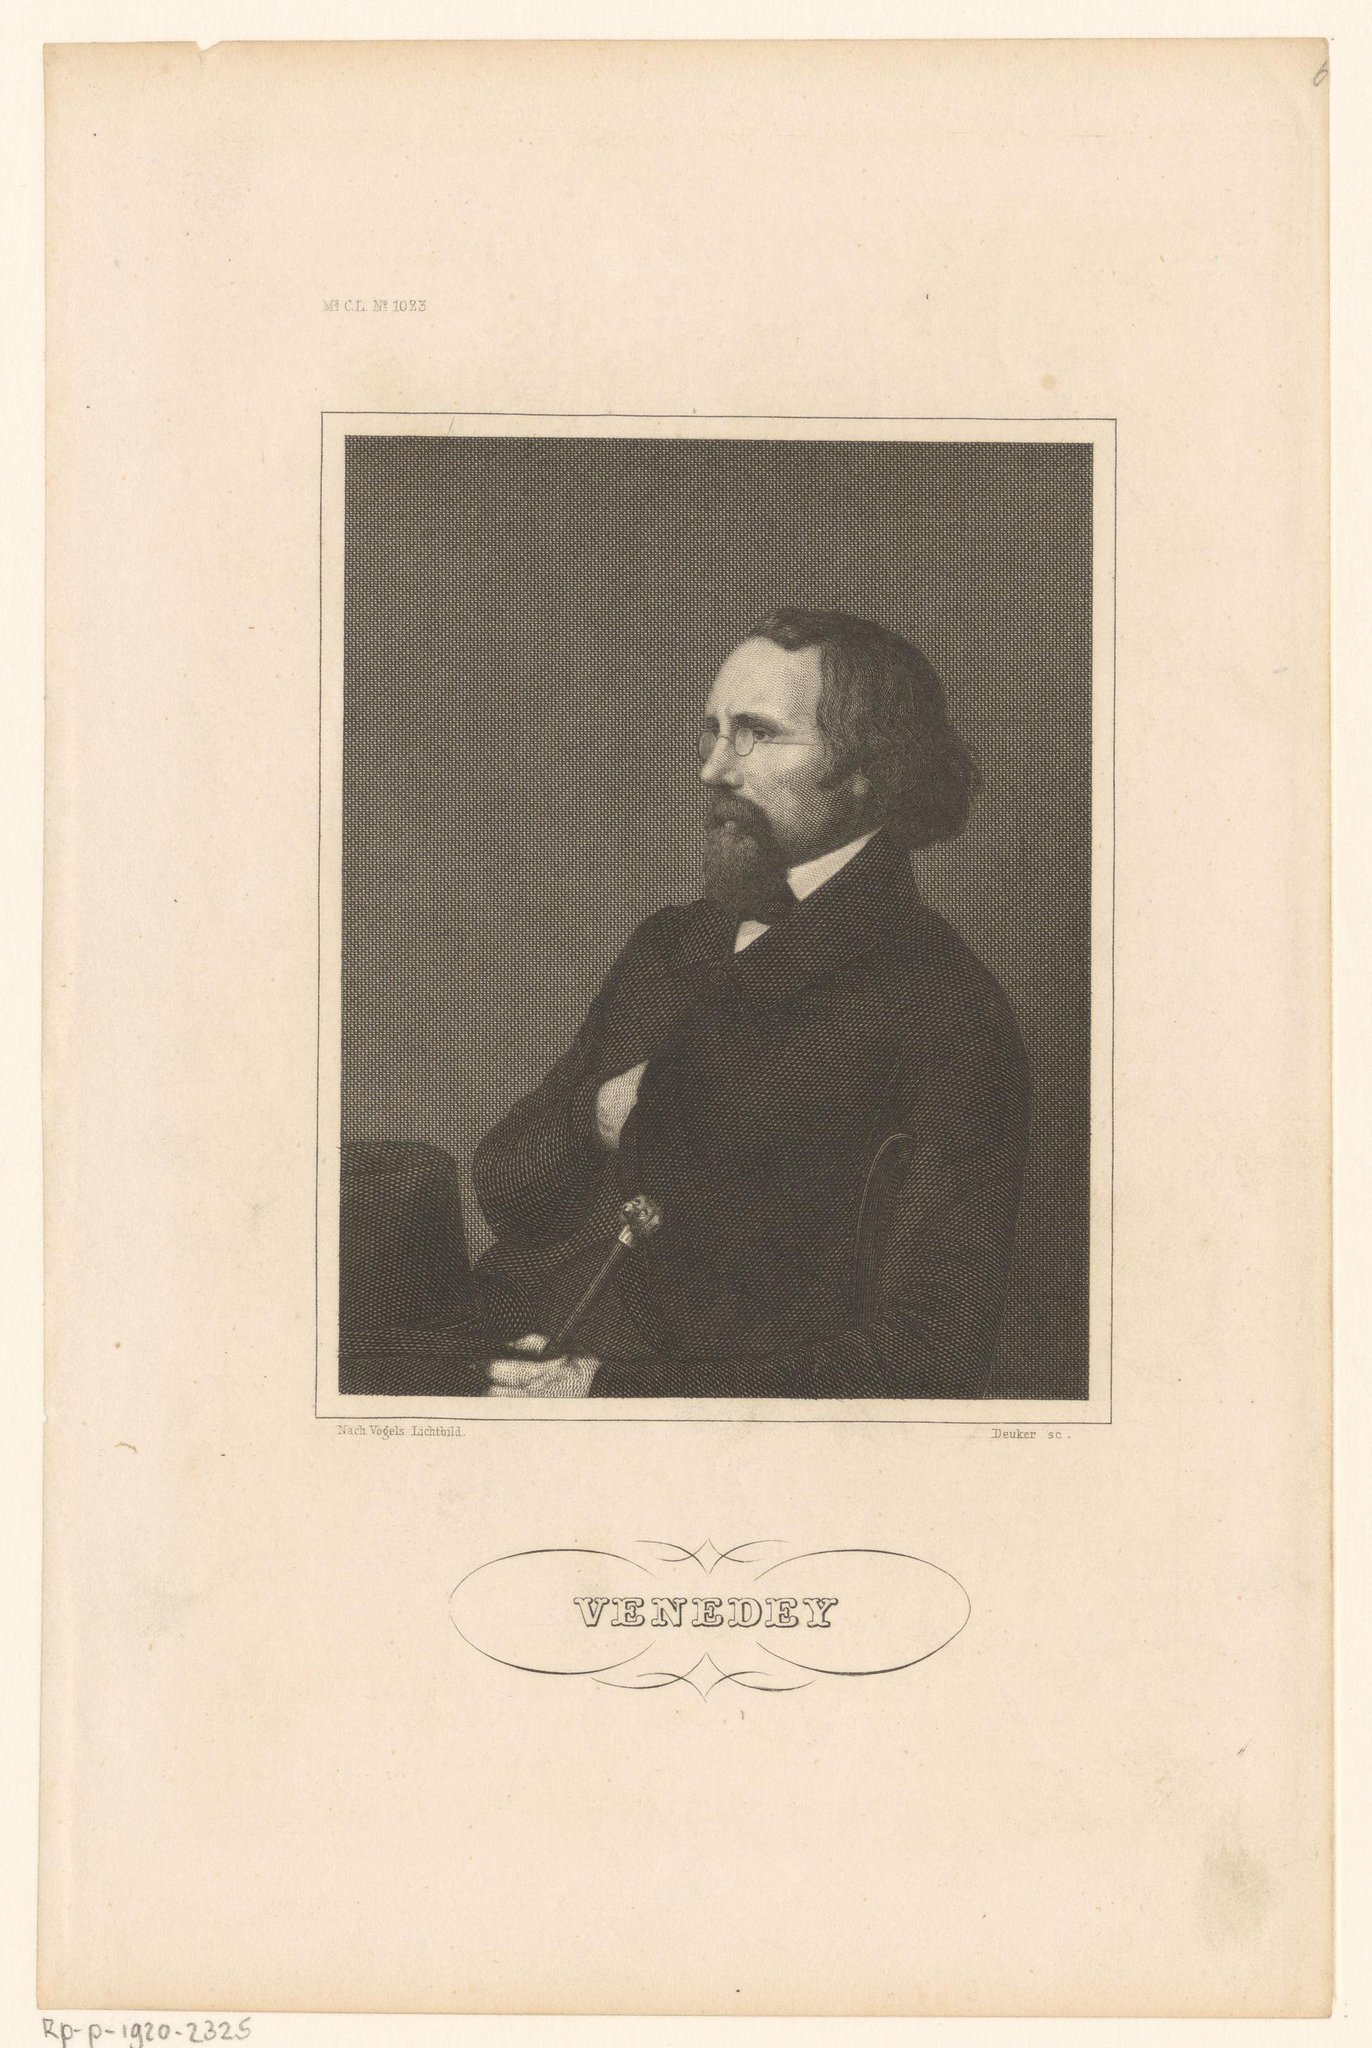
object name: book illustration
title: Portret van Jakob Venedey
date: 1840-1855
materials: paper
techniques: engraving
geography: germany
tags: politician, walking-stick, staff, portrait of a writer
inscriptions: collector's mark: Lugt 2228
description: Prent afkomstig uit: Conversations-Lexikon für die gebildeten Stände, voor het eerst uitgegeven tussen 1840-1855.